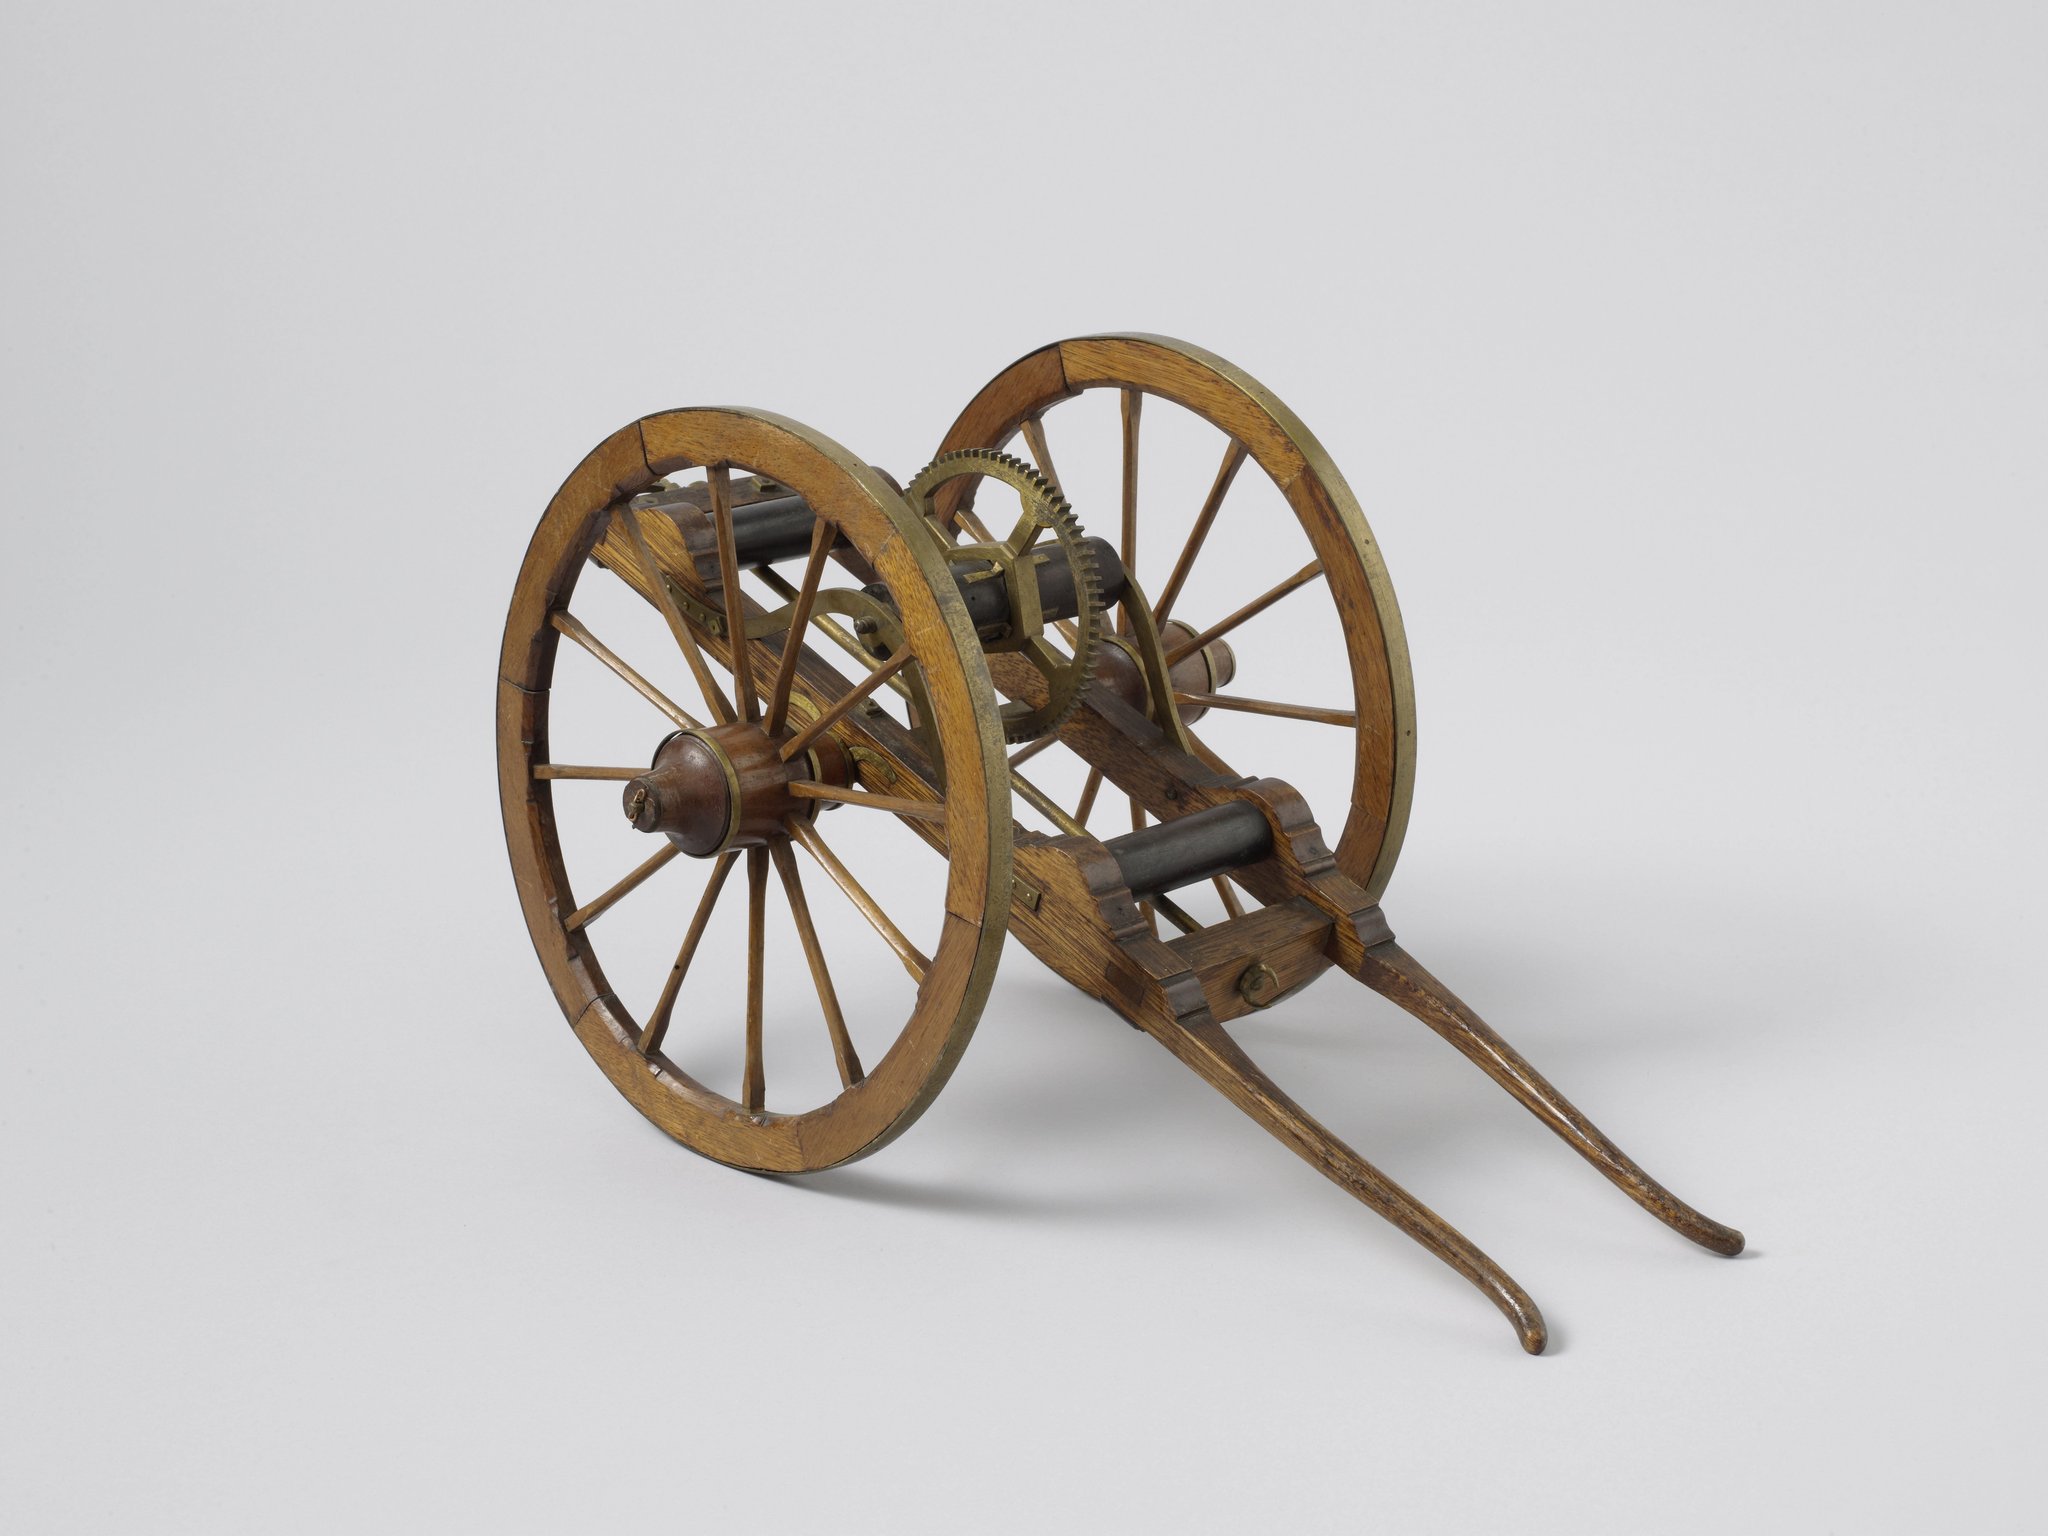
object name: demonstration model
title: Model of a Timber Wagon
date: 1797-1801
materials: brass, wood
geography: france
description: Model van een wagen met twee wielen zonder vloer, uitgerust met een lier. De lier bestaat uit een schroef-zonder-eind die het tandwiel van een windas aandrijft. De schacht van de schroef loopt door het frame van voor, waar de zwengel zit, naar achter. Voor en achter op het frame zit een houten roller.